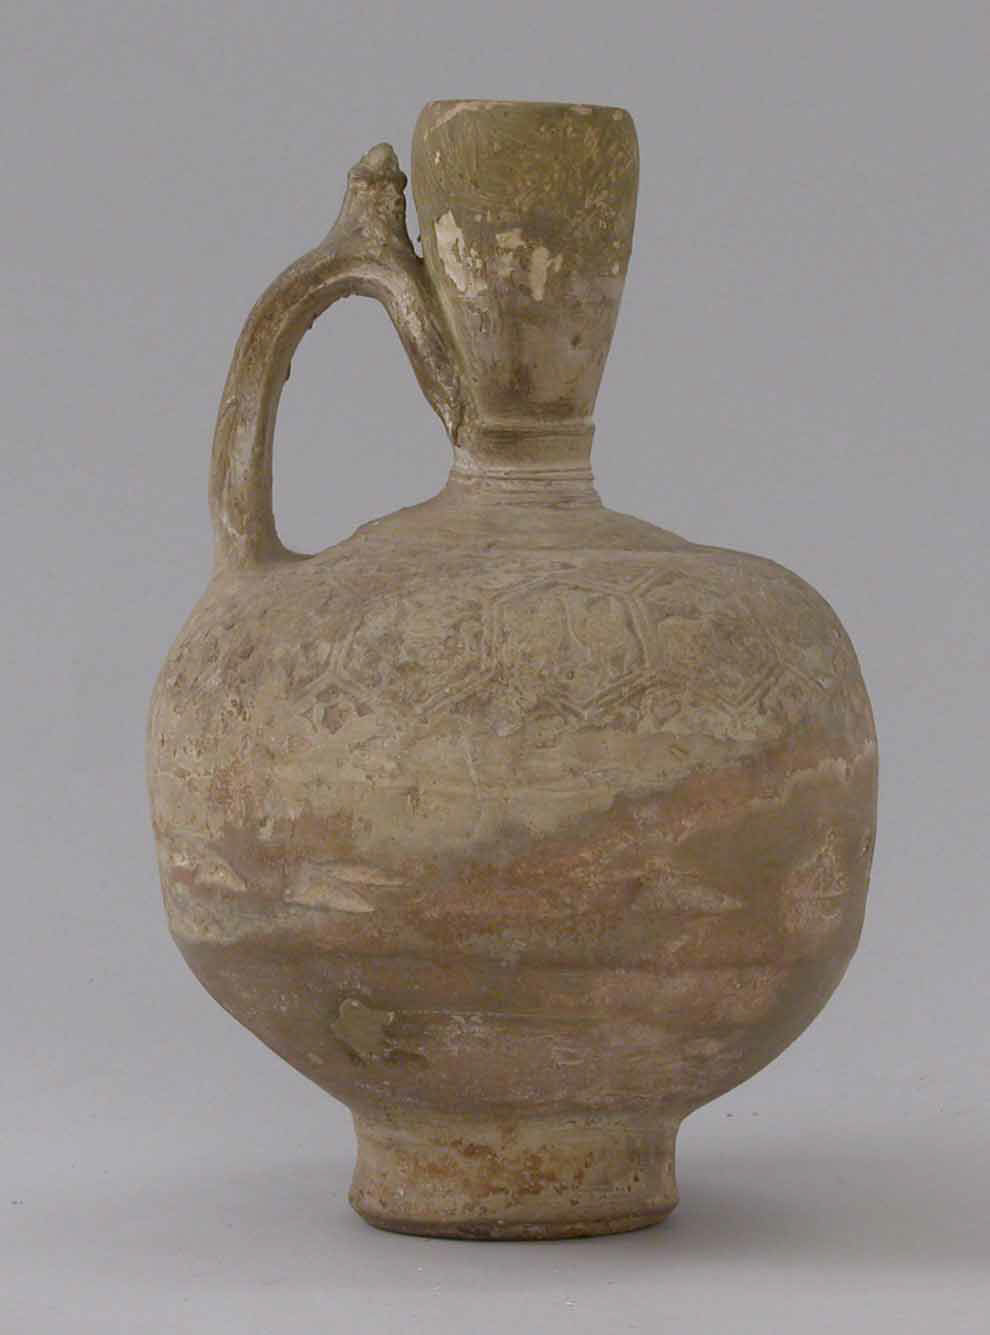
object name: ewer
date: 1001-1200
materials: earthenware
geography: iraq